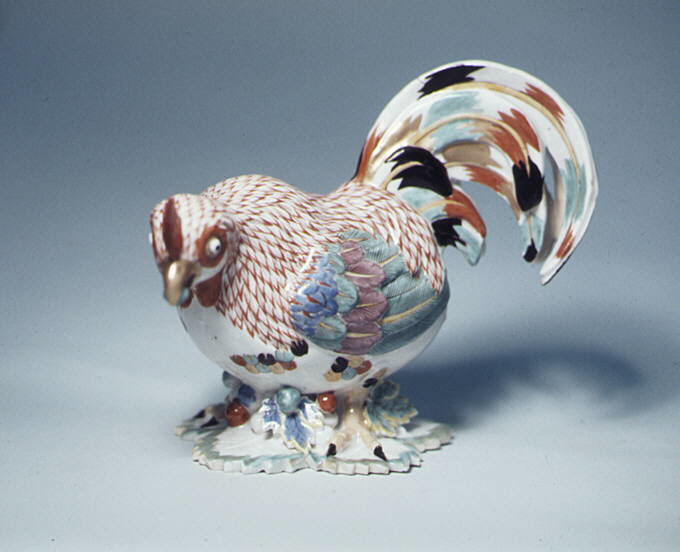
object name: figure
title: Chinese rooster (one of a pair)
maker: meissen manufactory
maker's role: manufactory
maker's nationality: german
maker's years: 1710-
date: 1732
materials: hard paste porcelain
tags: roosters